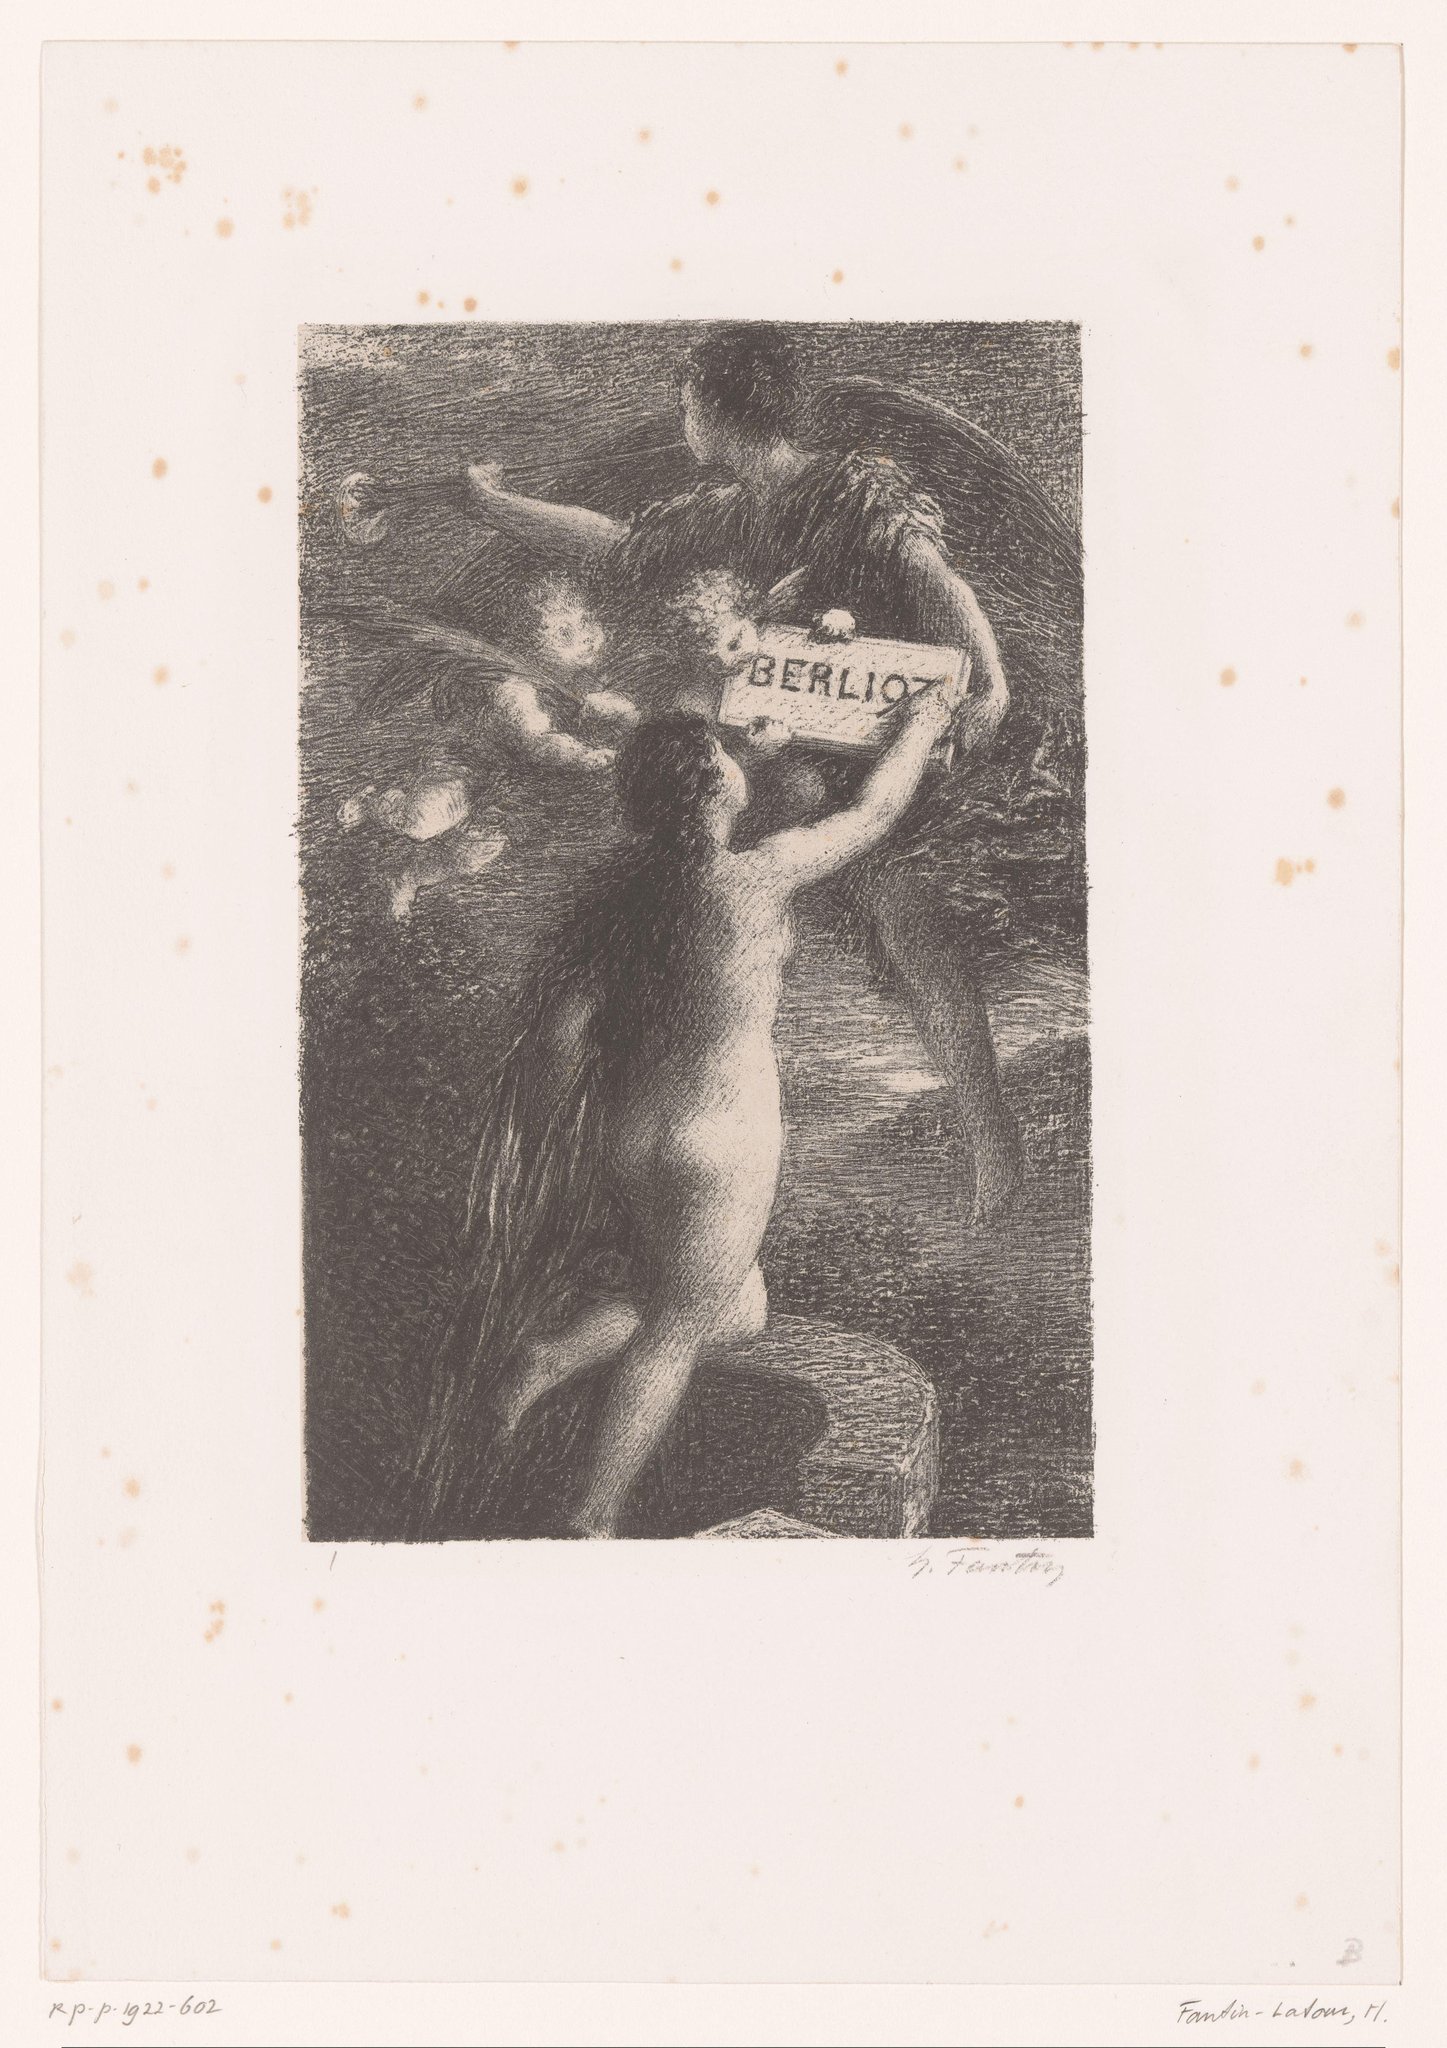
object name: print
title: Leven en werken van Hector Berlioz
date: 1888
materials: paper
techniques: lithography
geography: paris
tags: truth; 'verità' (ripa) (+ allegorical scene, i.e. two or more personifications involved in an action), cupids together with attributes of the arts, sciences, etc., angels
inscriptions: collector's mark: Lugt 2228a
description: Een jonge vrouw, de personificatie van de Waarheid, graveert de naam Berlioz op een steen.